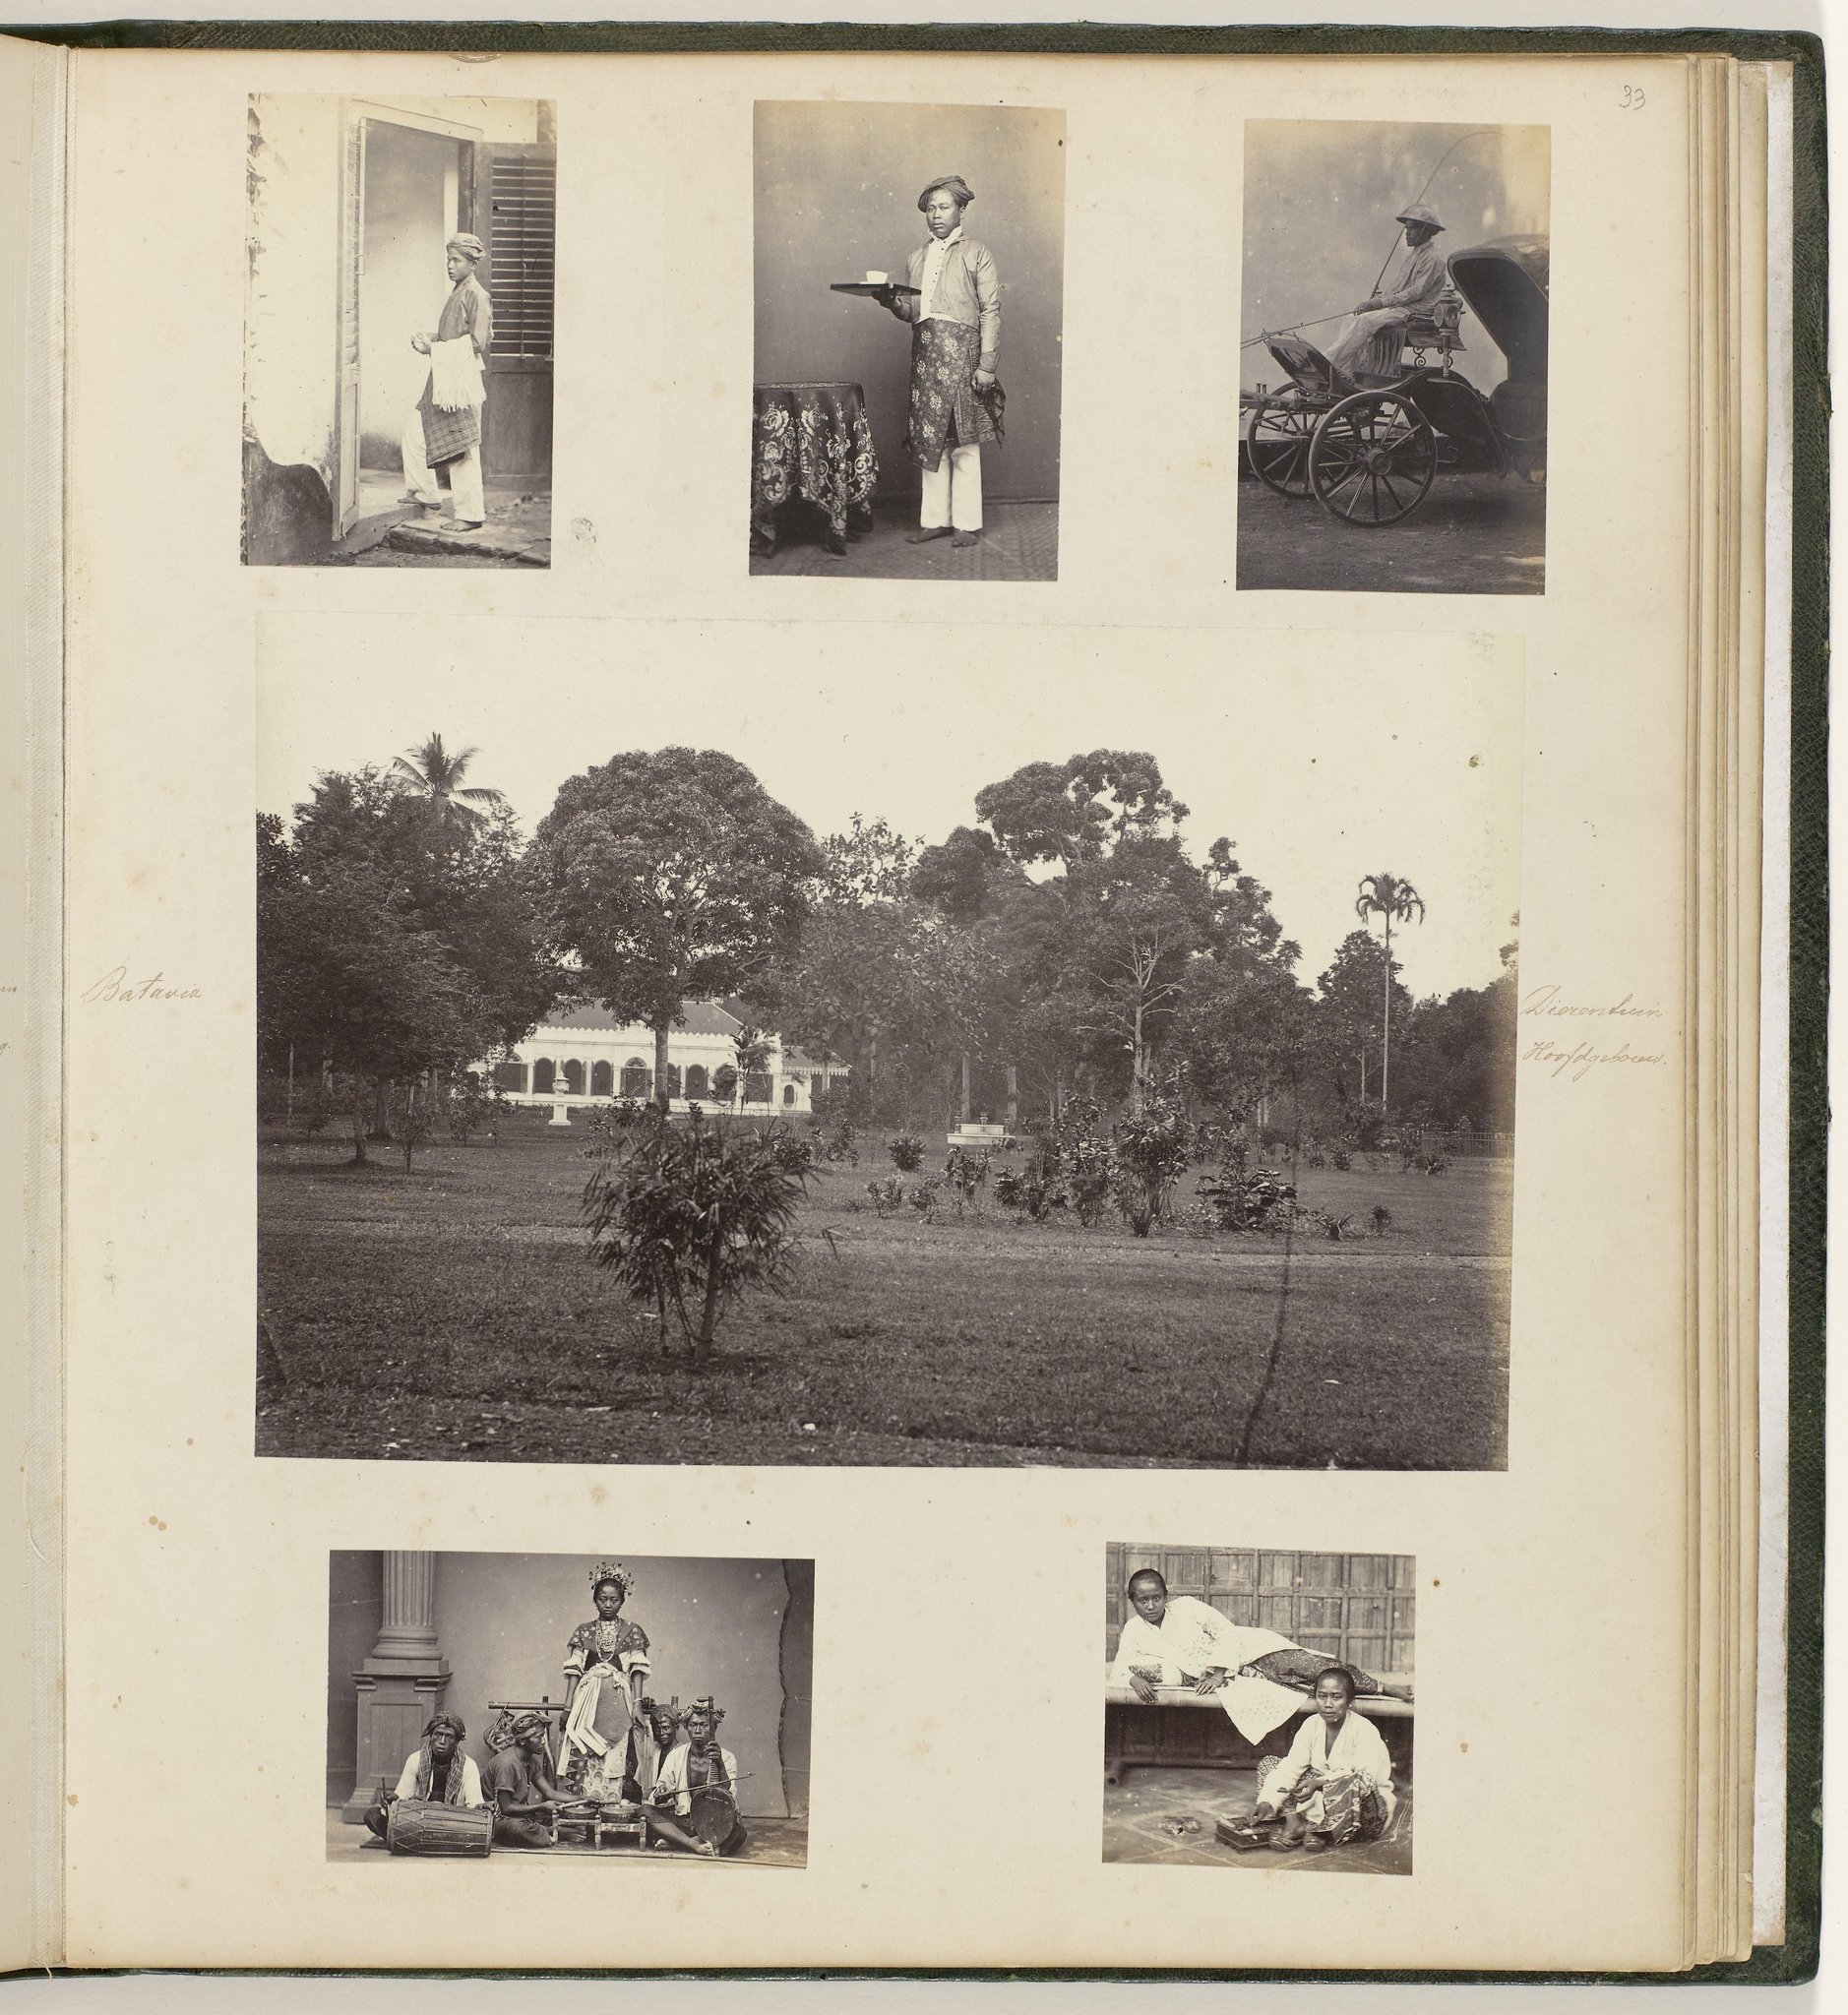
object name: album leaf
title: Dierentuin, beroepen en Wajang Topeng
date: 1864-1866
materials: cardboard, photographic support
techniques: albumen print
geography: batavia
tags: small group of musicians, chamber orchestra, jazz band, woman dancing alone, zoo (as place of recreation), historical persons not known by name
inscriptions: inscription: ‘Batavia / Dierentuin Hoofdgebouw’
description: Albumblad met zes foto's. Centraal een gezicht op het hoofdgebouw van de Planten- en Dierentuin (opgericht in 1864) in Batavia. Boven drie portretten van Javaanse mannen in beroepen, onderaan twee foto's van een danseres met muzikanten van wajang topeng en twee vrouwen. Onderdeel van het tweede groene fotoalbum met foto's van Java, uit het bezit van apotheker Specht-Grijp, die in 1865 vanuit Batavia naar Nederland terugkeerde.